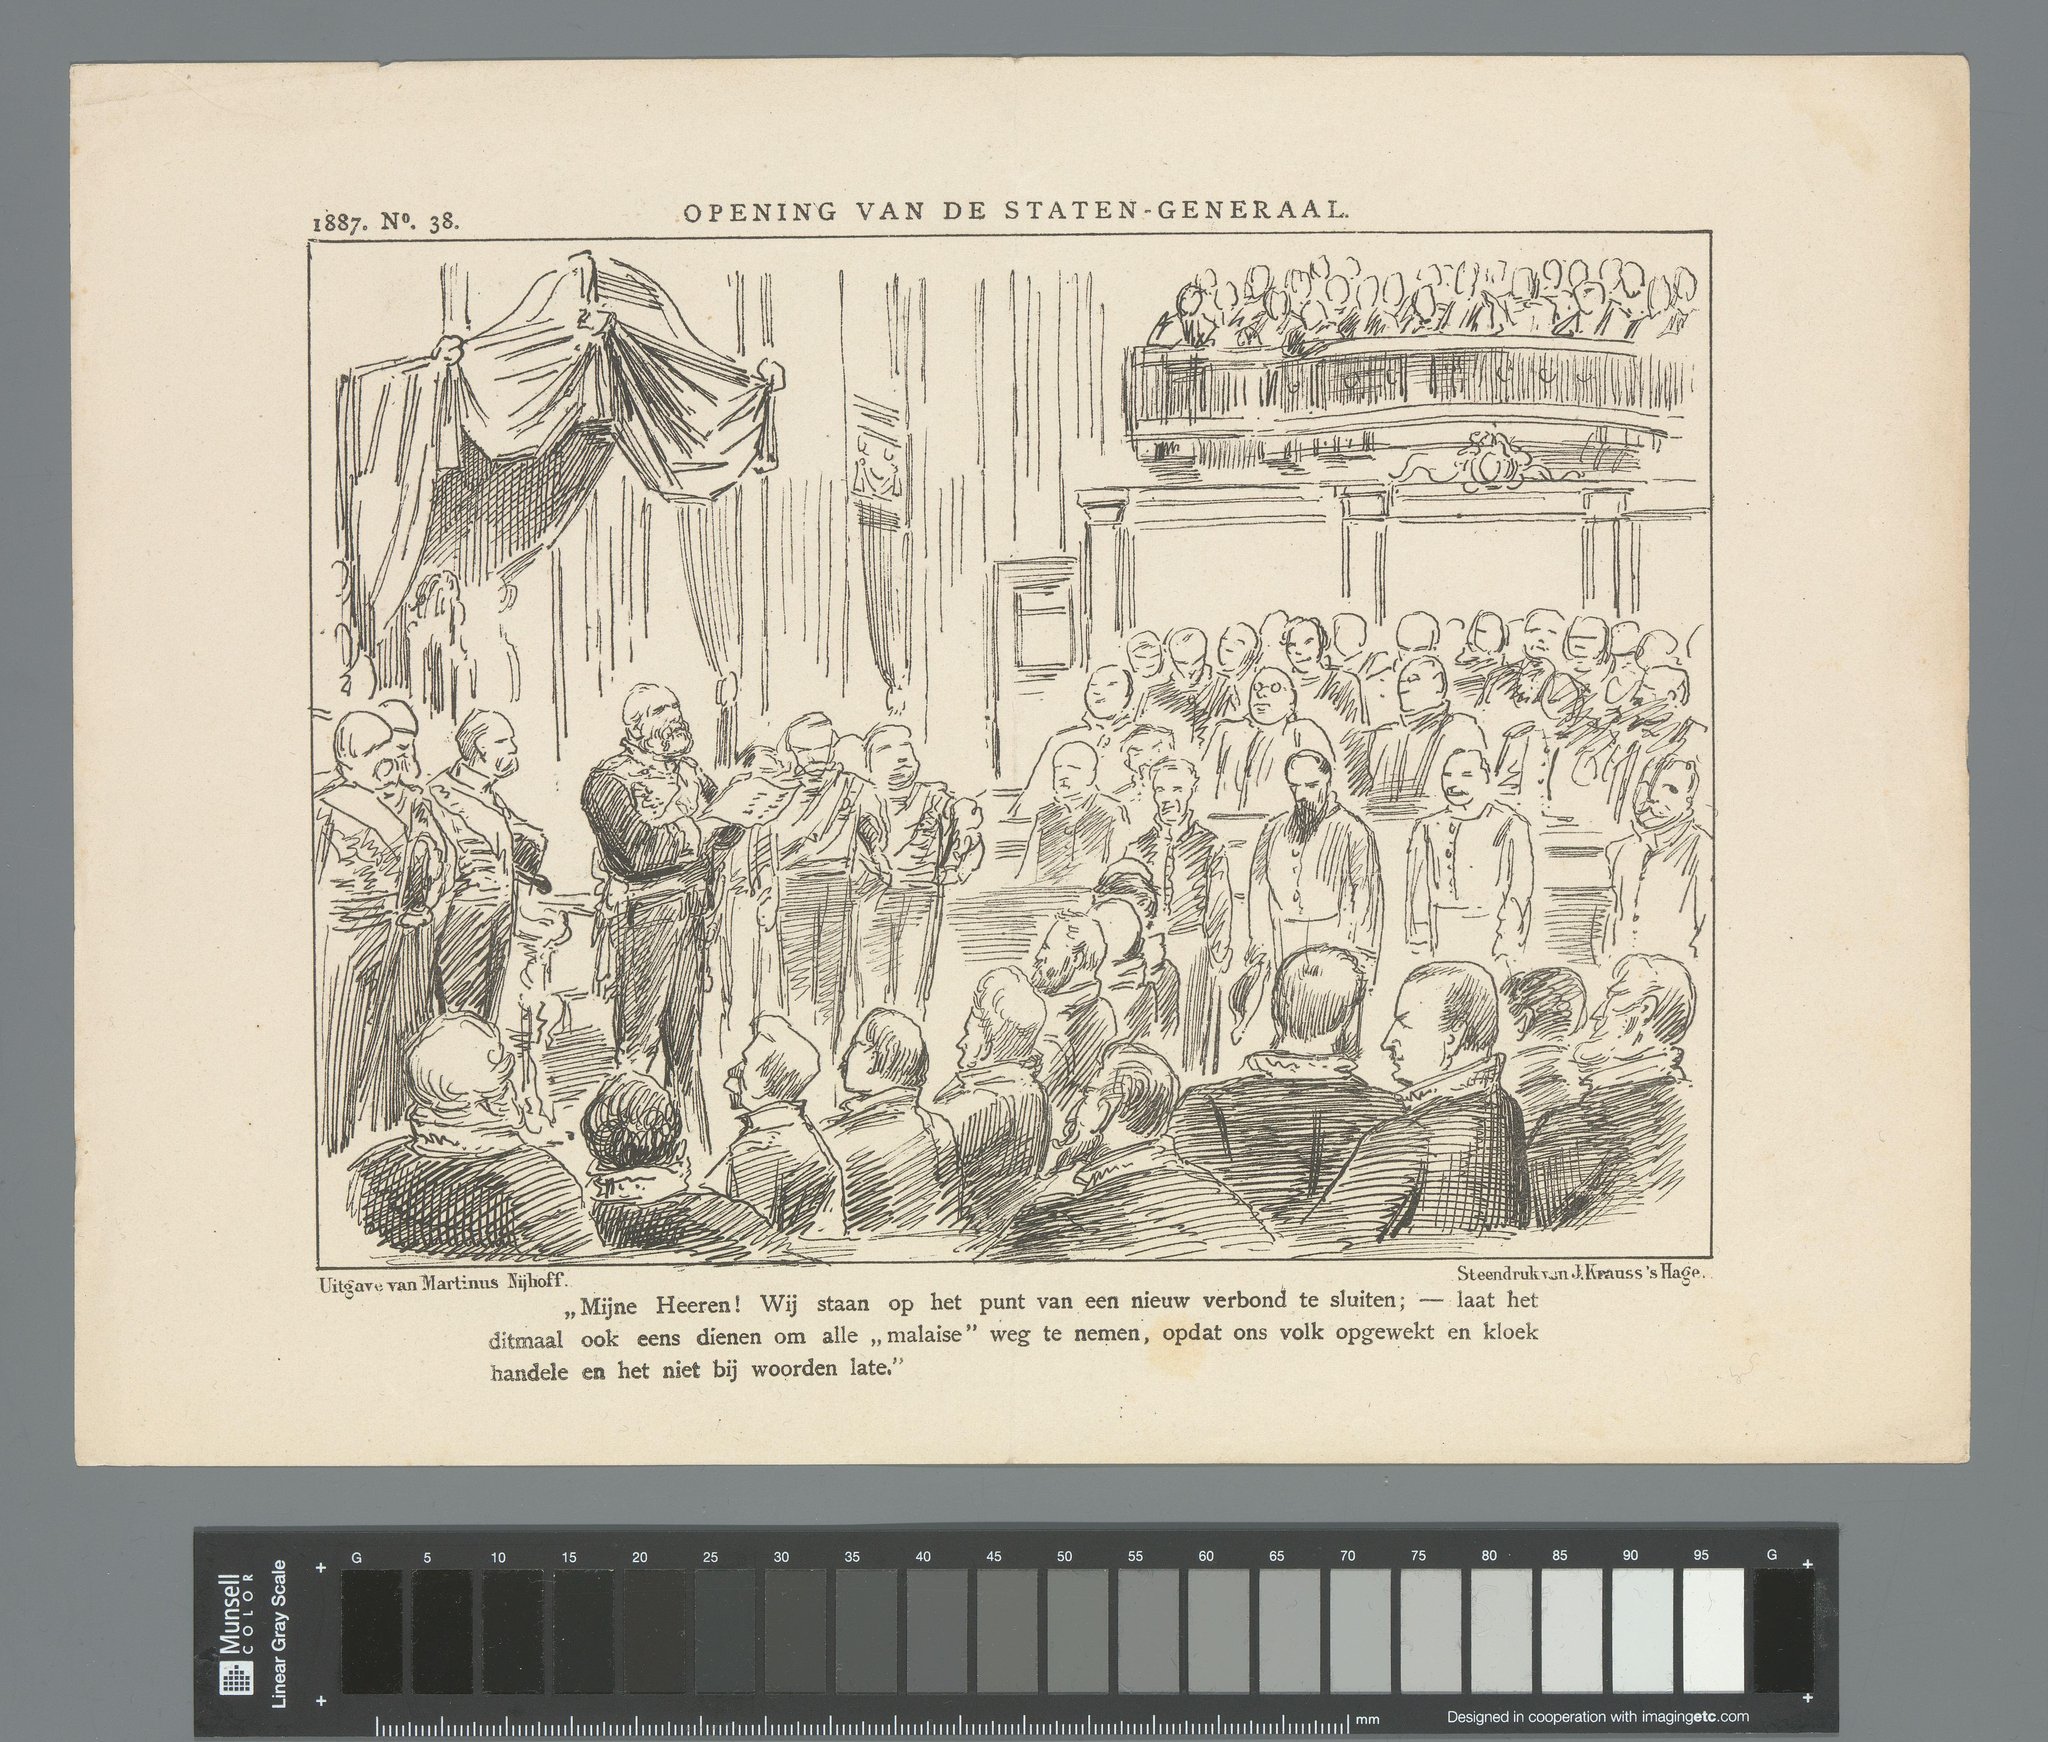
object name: print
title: Opening van de Staten-Generaal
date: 1887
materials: paper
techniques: lithograph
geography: the hague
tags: brussels, willem iii (koning der nederlanden)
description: Bij de opening van de Staten-Generaal: koning Willem III spreekt. Plaat verschenen bij het weekblad De Nederlandsche Spectator, nr. 38, 1887.